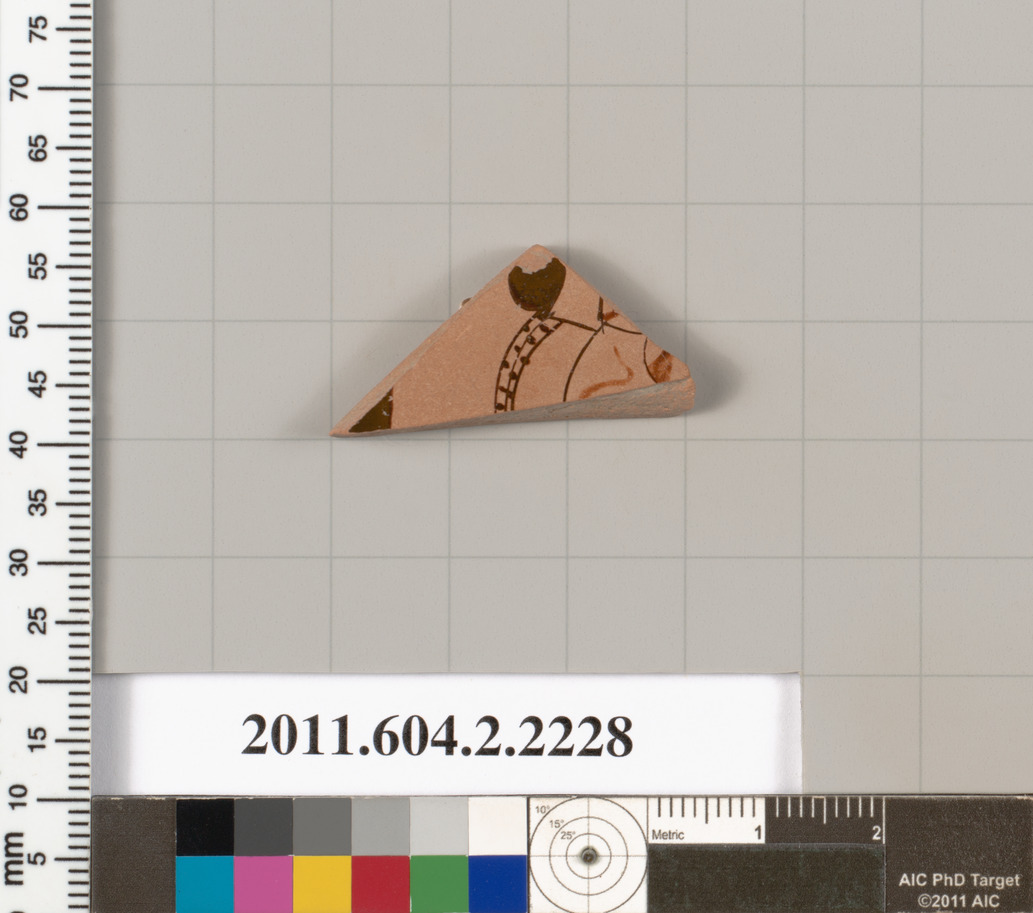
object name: pot fragment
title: Terracotta fragment of a pot; unglazed on the inside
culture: greek, attic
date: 460-440 BCE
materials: terracotta